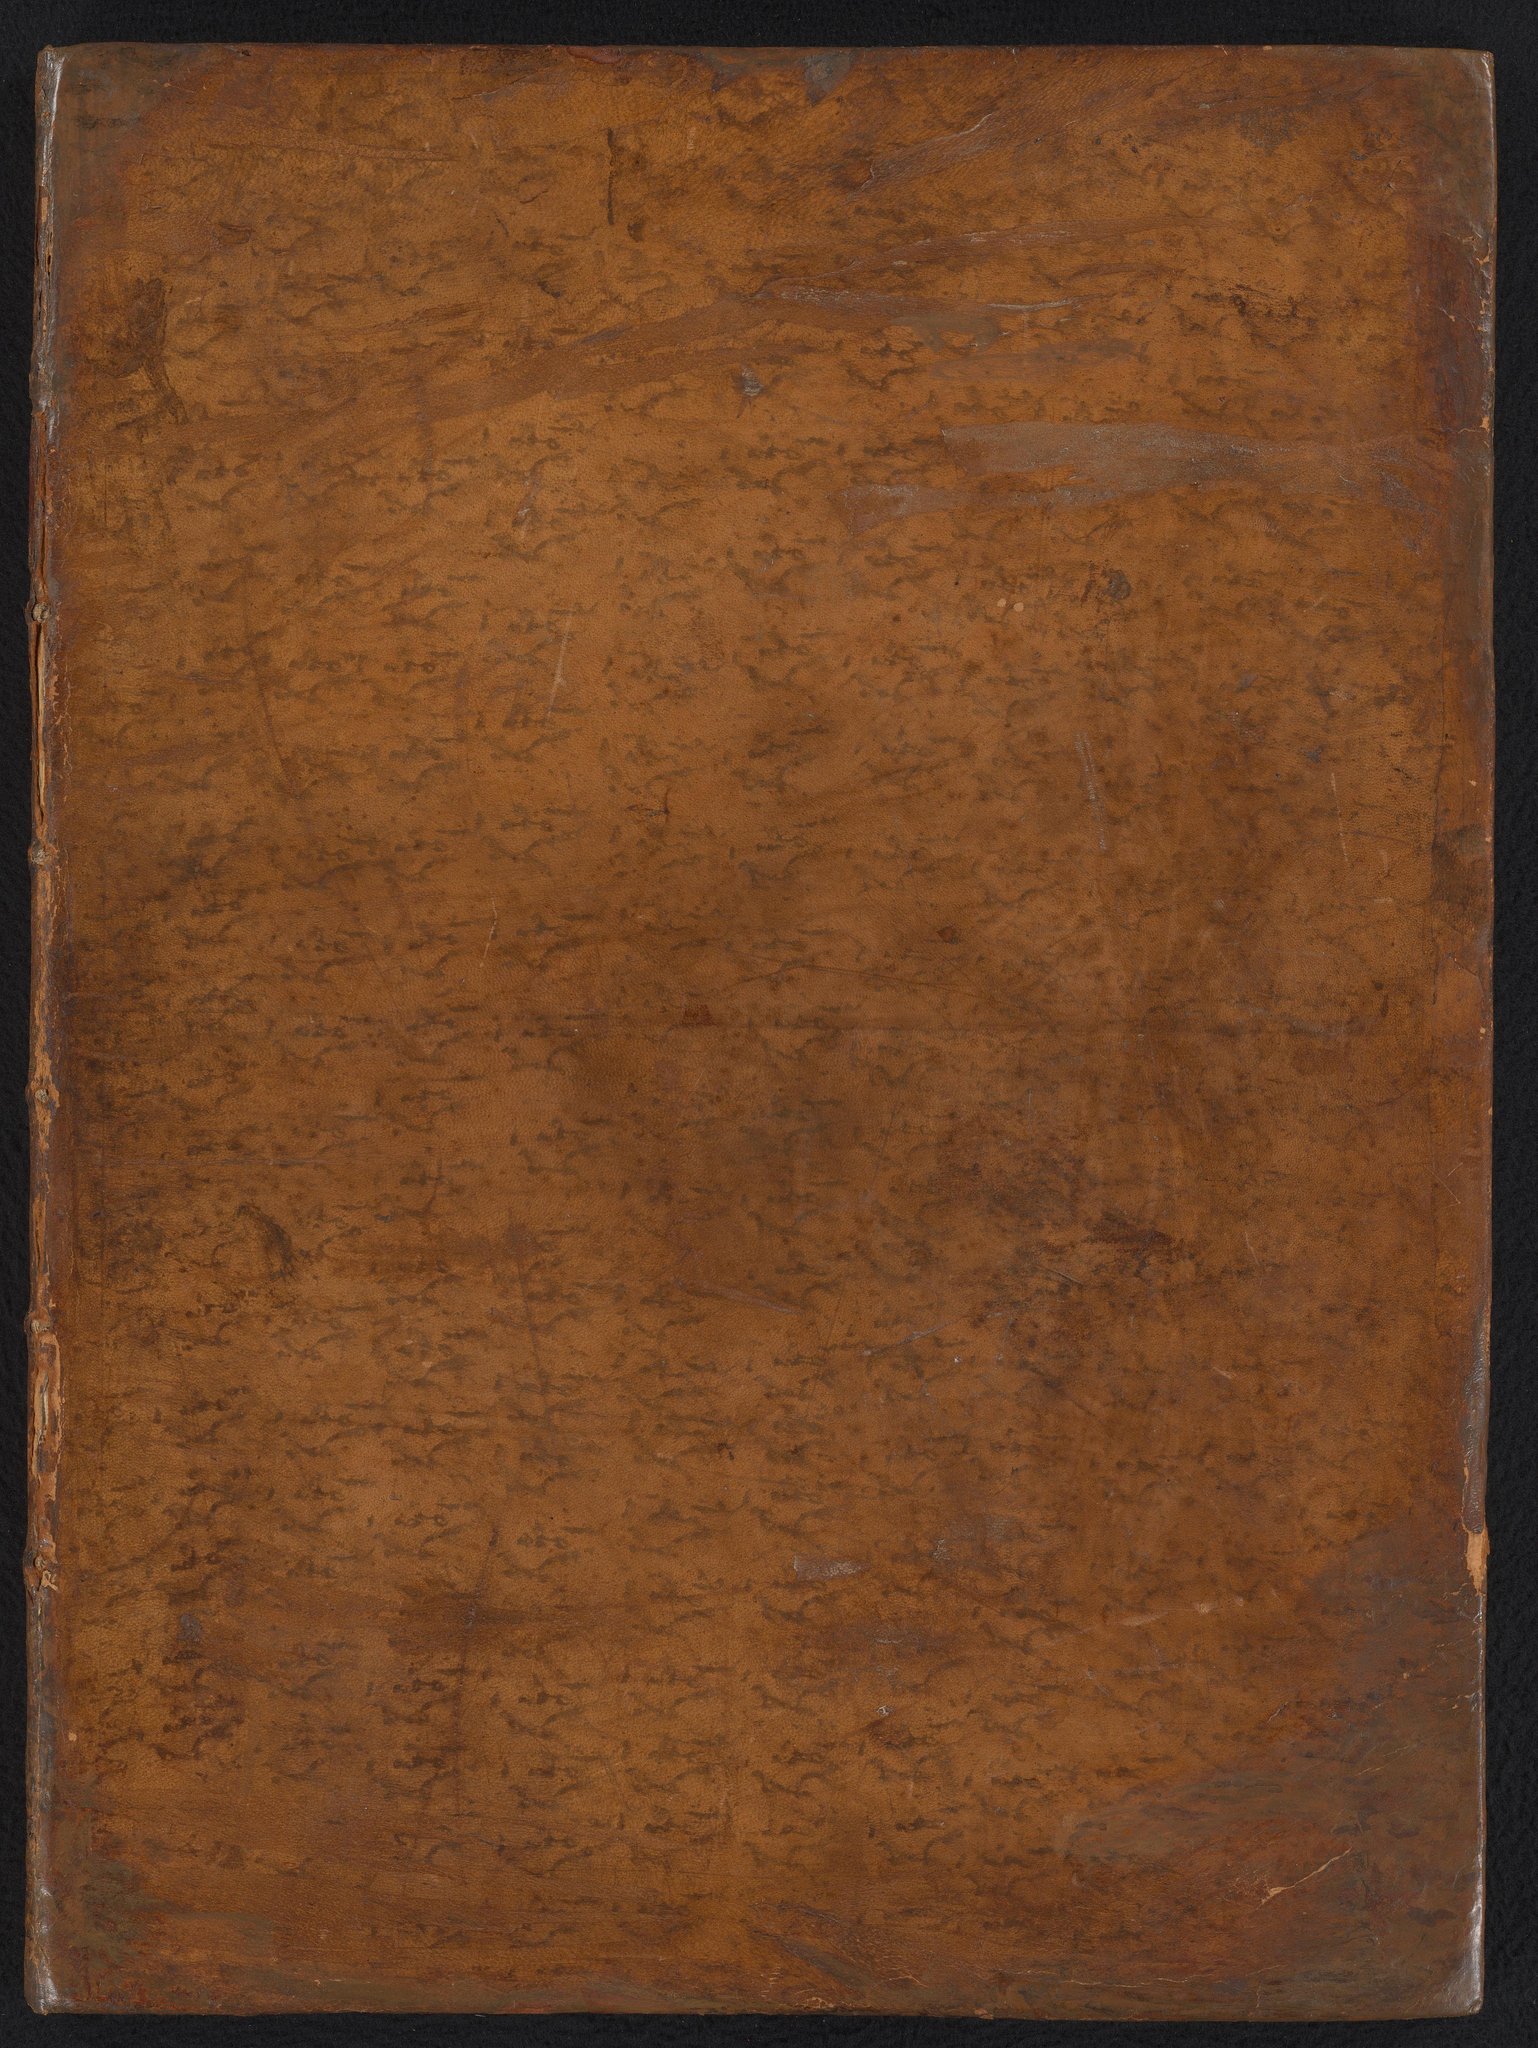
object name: prentrecueil, prentenalbum, prentalbum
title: Album met een deel van het oeuvre van Juste Aurèle Meissonnier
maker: gabriel huquier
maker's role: painter, print maker, publisher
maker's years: 1695-1772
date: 1738-1749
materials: cardboard, paper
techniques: bookbinding, printing, etching, marbling, marbled paper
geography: paris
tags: chandelier, candelabrum, jeweller, goldsmith, silversmith, work of applied art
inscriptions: collector's mark: Lugt 3669, collector's mark: Lugt 2261b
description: Naast Huquier, zijn Audran, Aveline, Allouis, Babel, Beauvais, Chedel, Chenu, Dubreulié, Desplaces, Hérisset, Laureolli en Riolet als graveurs betrokken bij deze uitgave. Zie deelrecords voor een beschrijving per prent. De publicatiedatum van dit werk is onduidelijk. De datering 1738-1749 is gebaseerd op het veel van de prenten voorkomende adres van de uitgever: "Rue st. Jacque au coin de celle des Mathurins", waar Huquier van 1738 tot 1749 gevestigd was.